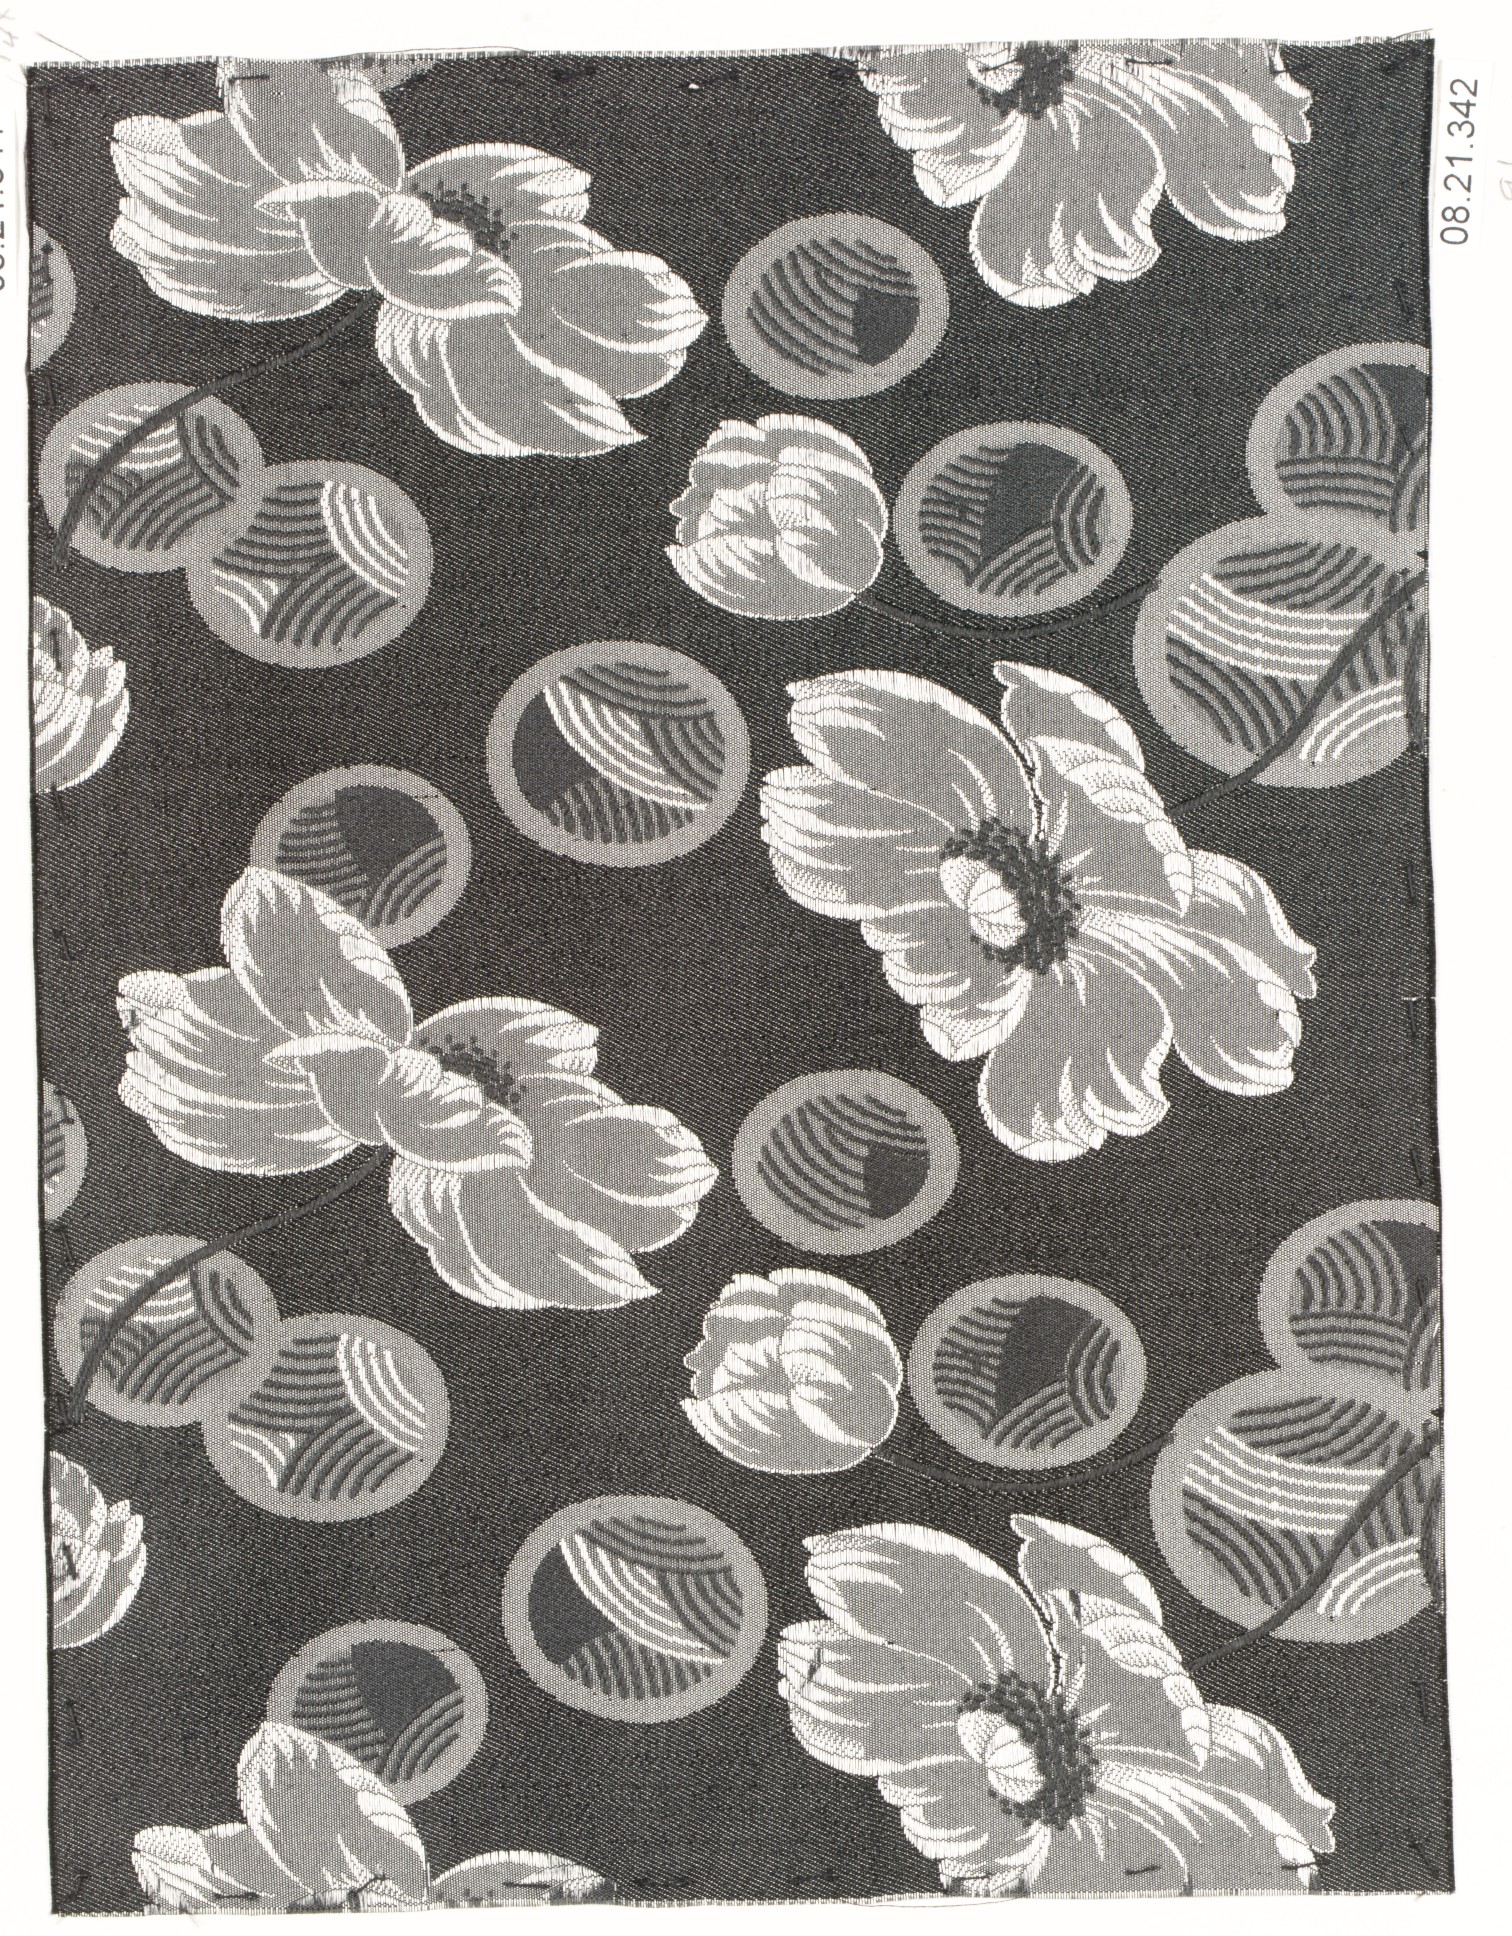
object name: textile sample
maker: Anonymous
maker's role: designer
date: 1900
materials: silk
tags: flowers